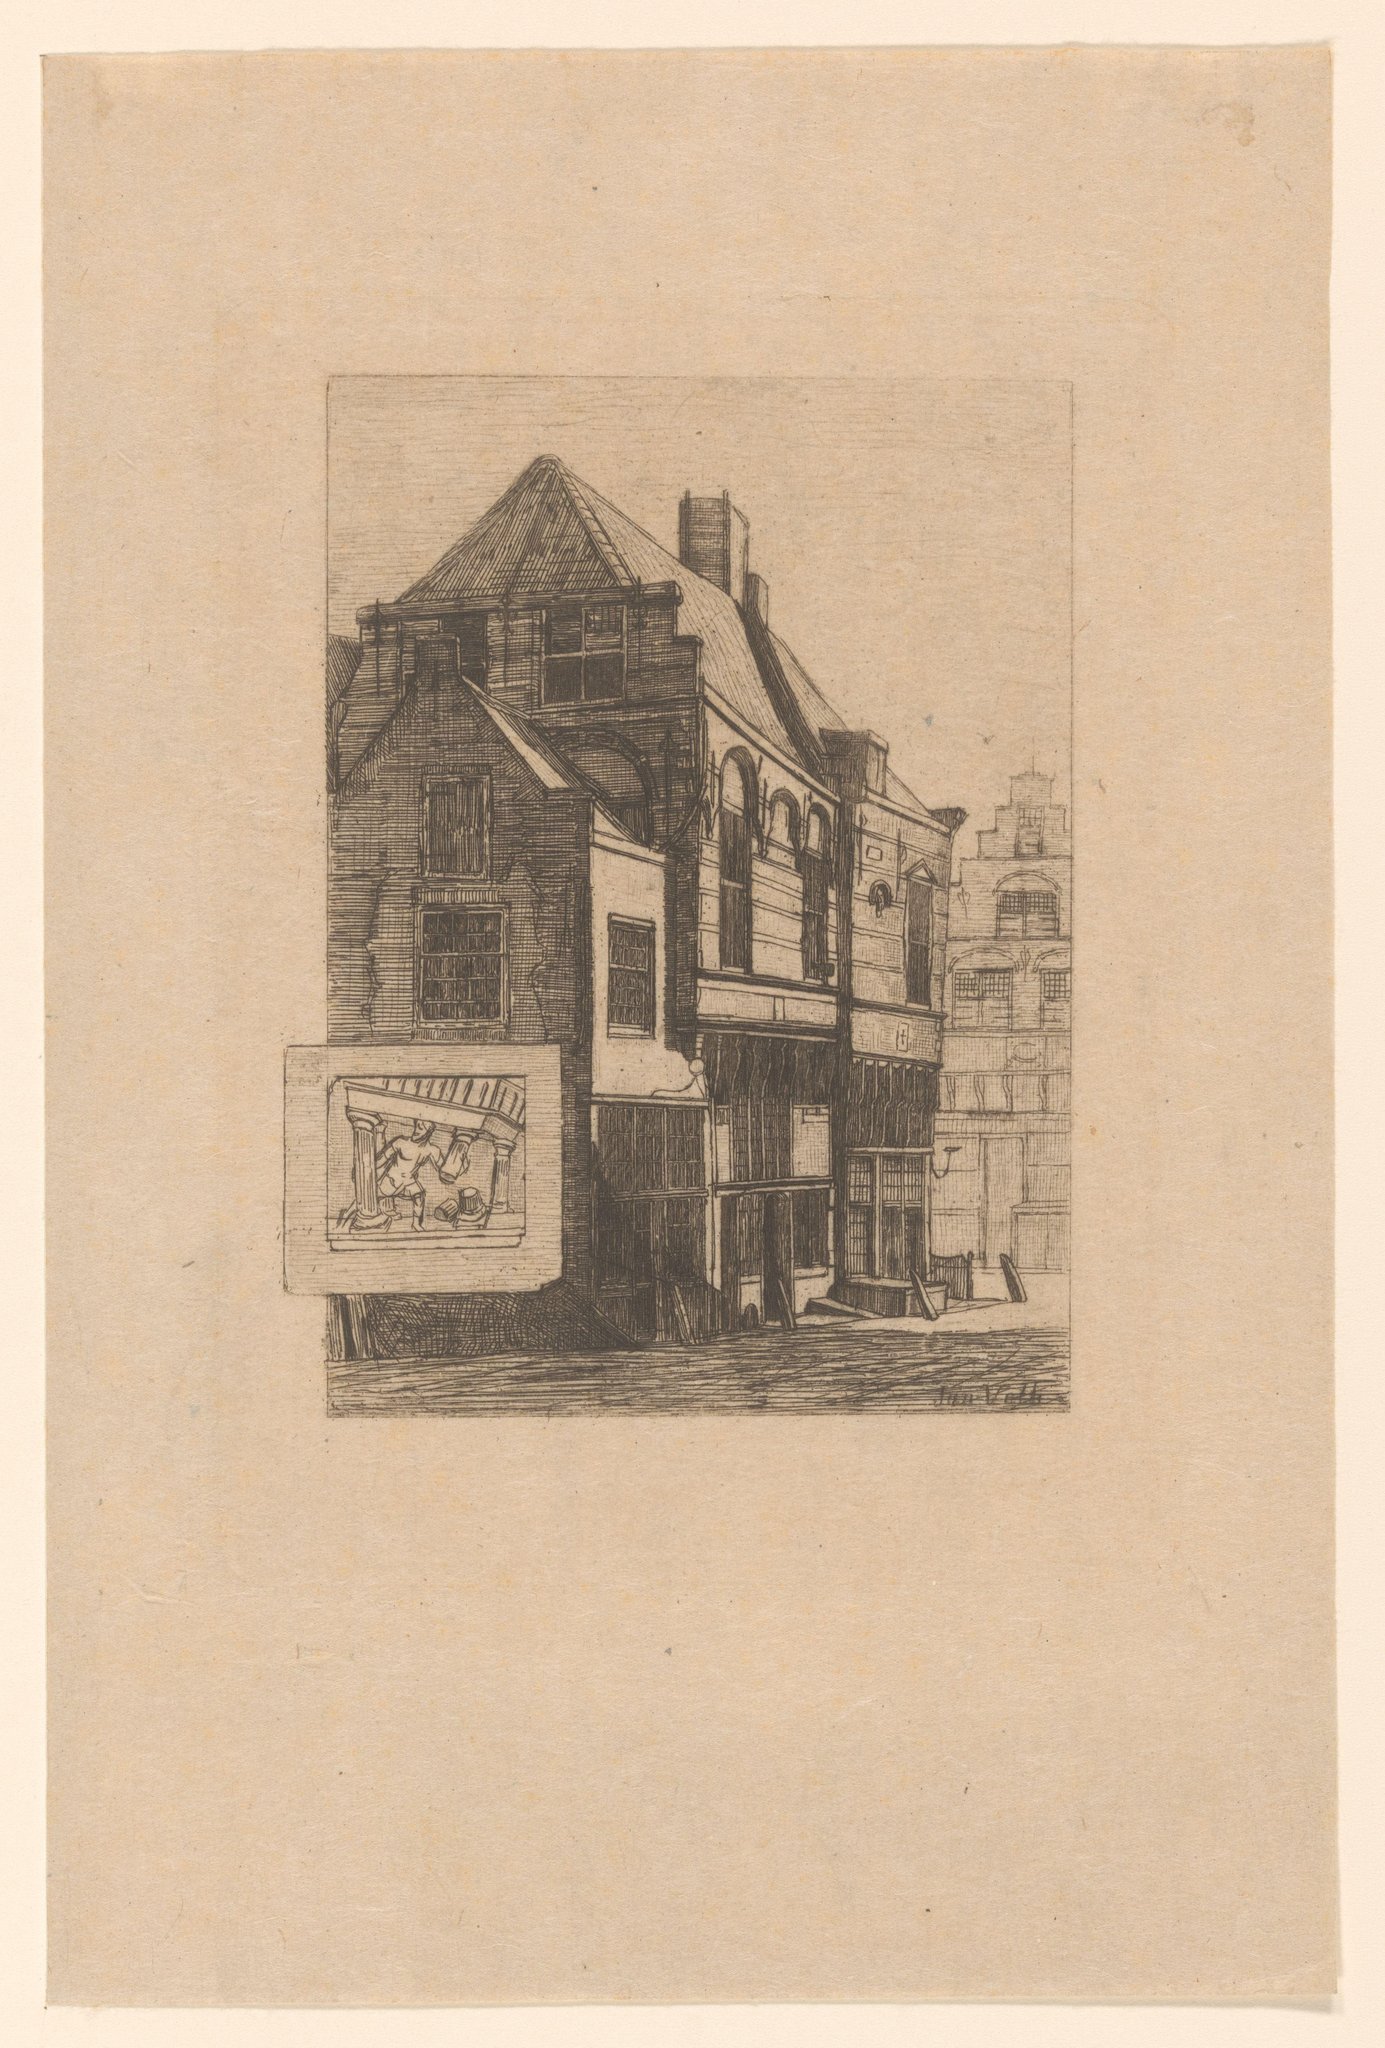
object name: print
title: Het huis Samson, te Dordrecht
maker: jan veth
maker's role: designer, draughtsman, painter, print maker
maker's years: 1864-1925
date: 1885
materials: paper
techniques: etching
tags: urban housing, dordrecht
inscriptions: collector's mark: Lugt 2228